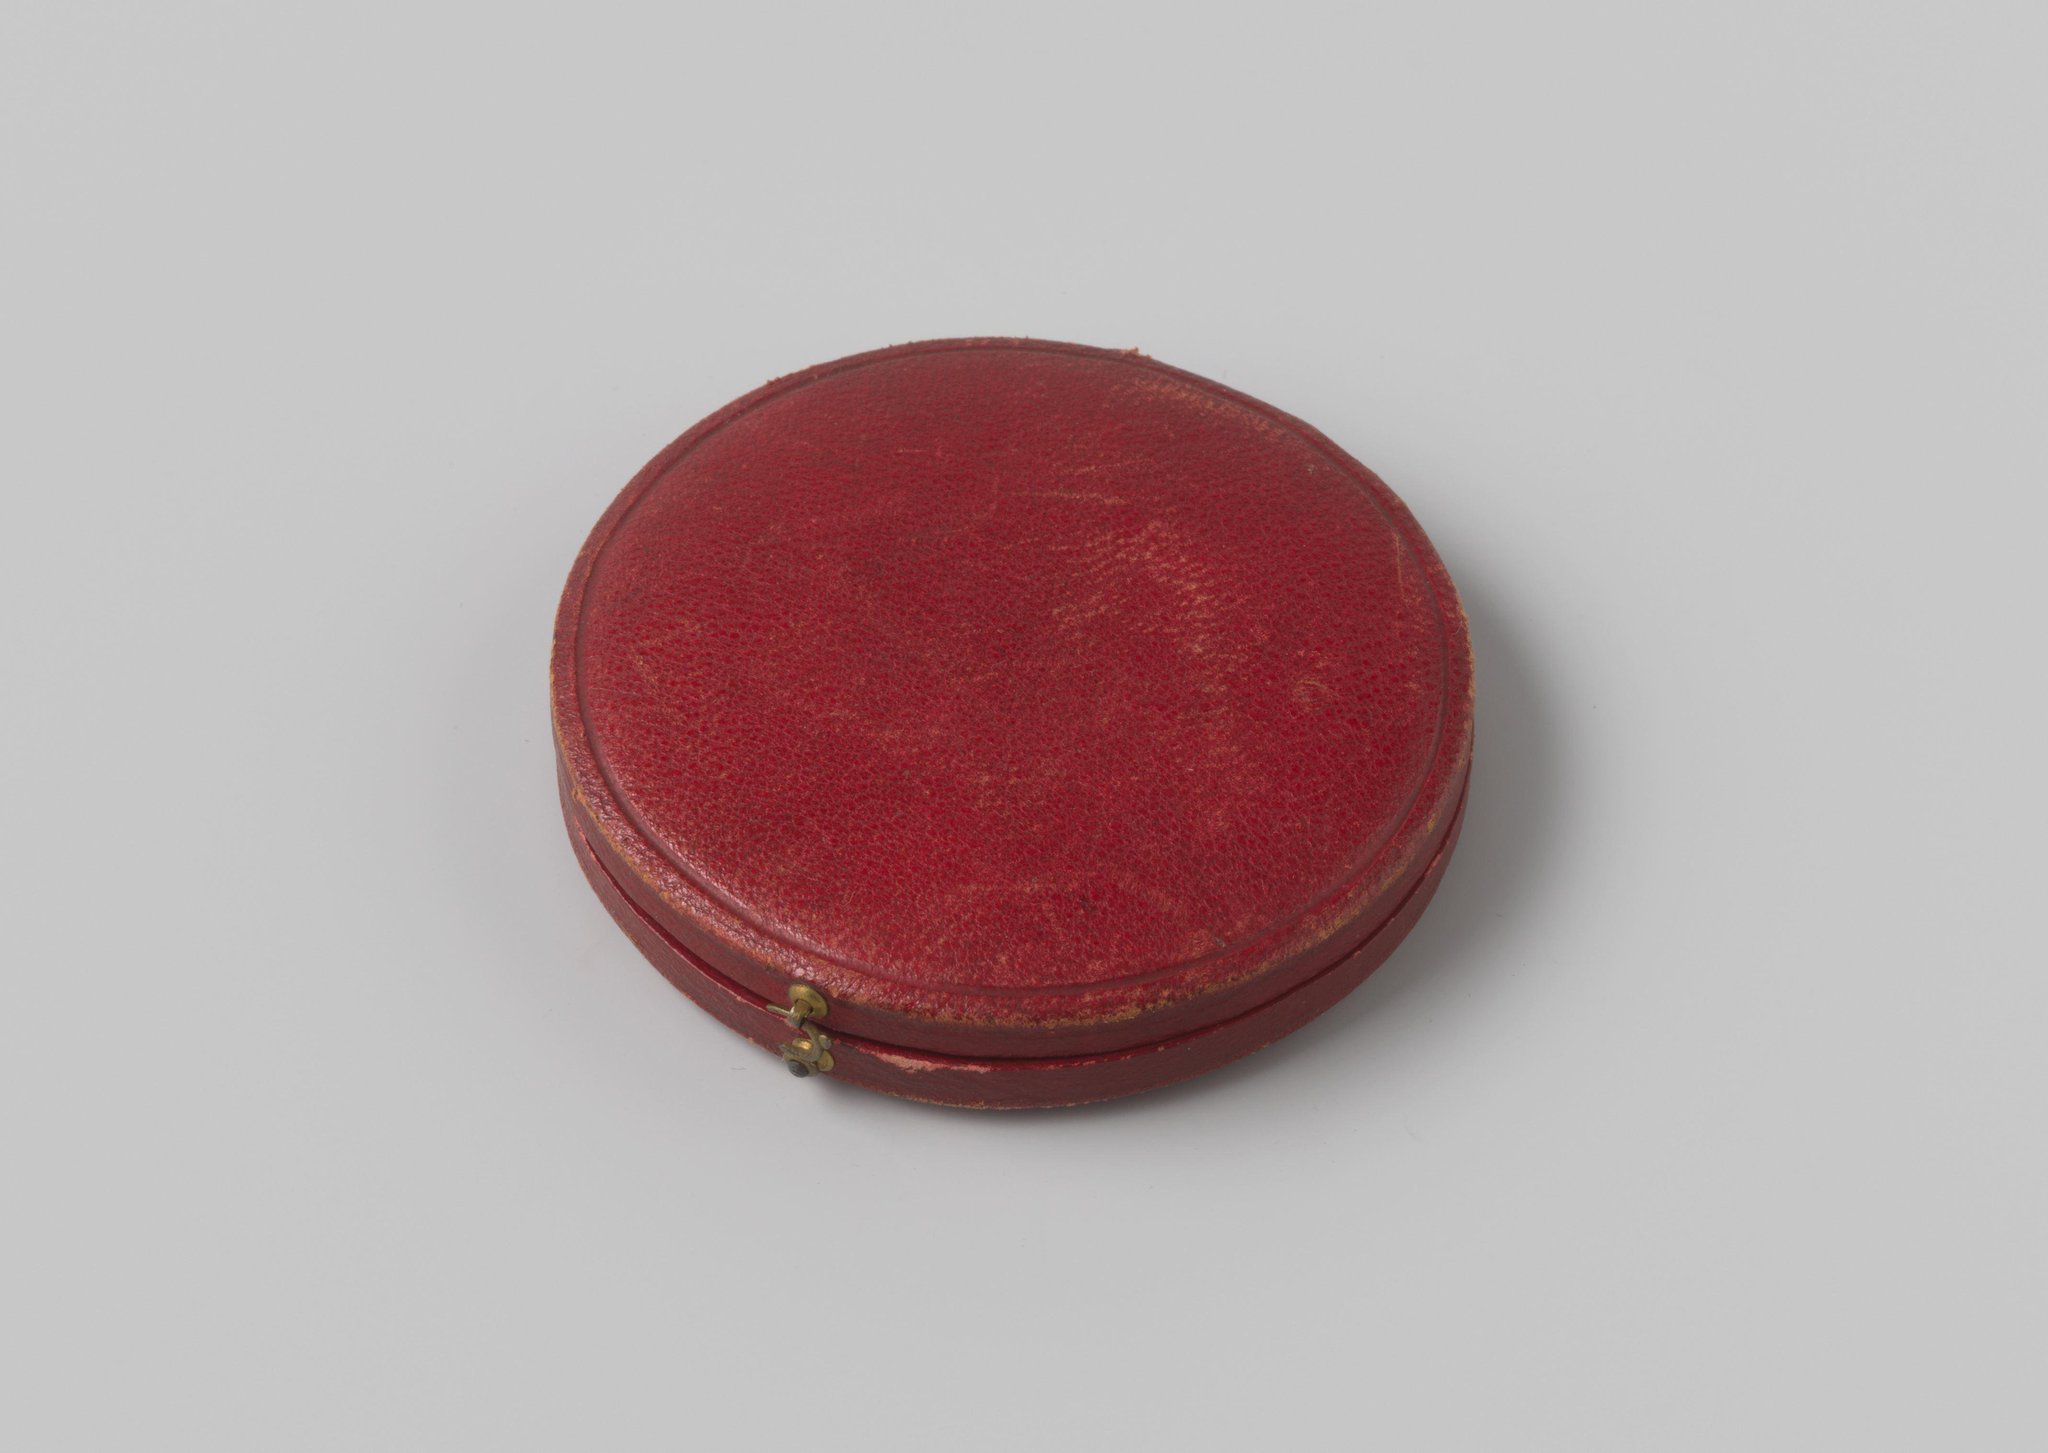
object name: medal box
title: Doosje behorende bij de prijspenning uitgereikt aan Bart van Hove op de internationale wereldtentoonstelling te Parijs, 1878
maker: Anonymous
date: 1875-1878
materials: cardboard, paper, velvet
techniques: pasting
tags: the hague, amsterdam, sculptor, bart van hove, paris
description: Rond kartonnen doosje met rood leer beplakt met koperen haakje als sluiting en scharnierend aan de achterzijde. Binnenzijde blauw fluweel met lintje.